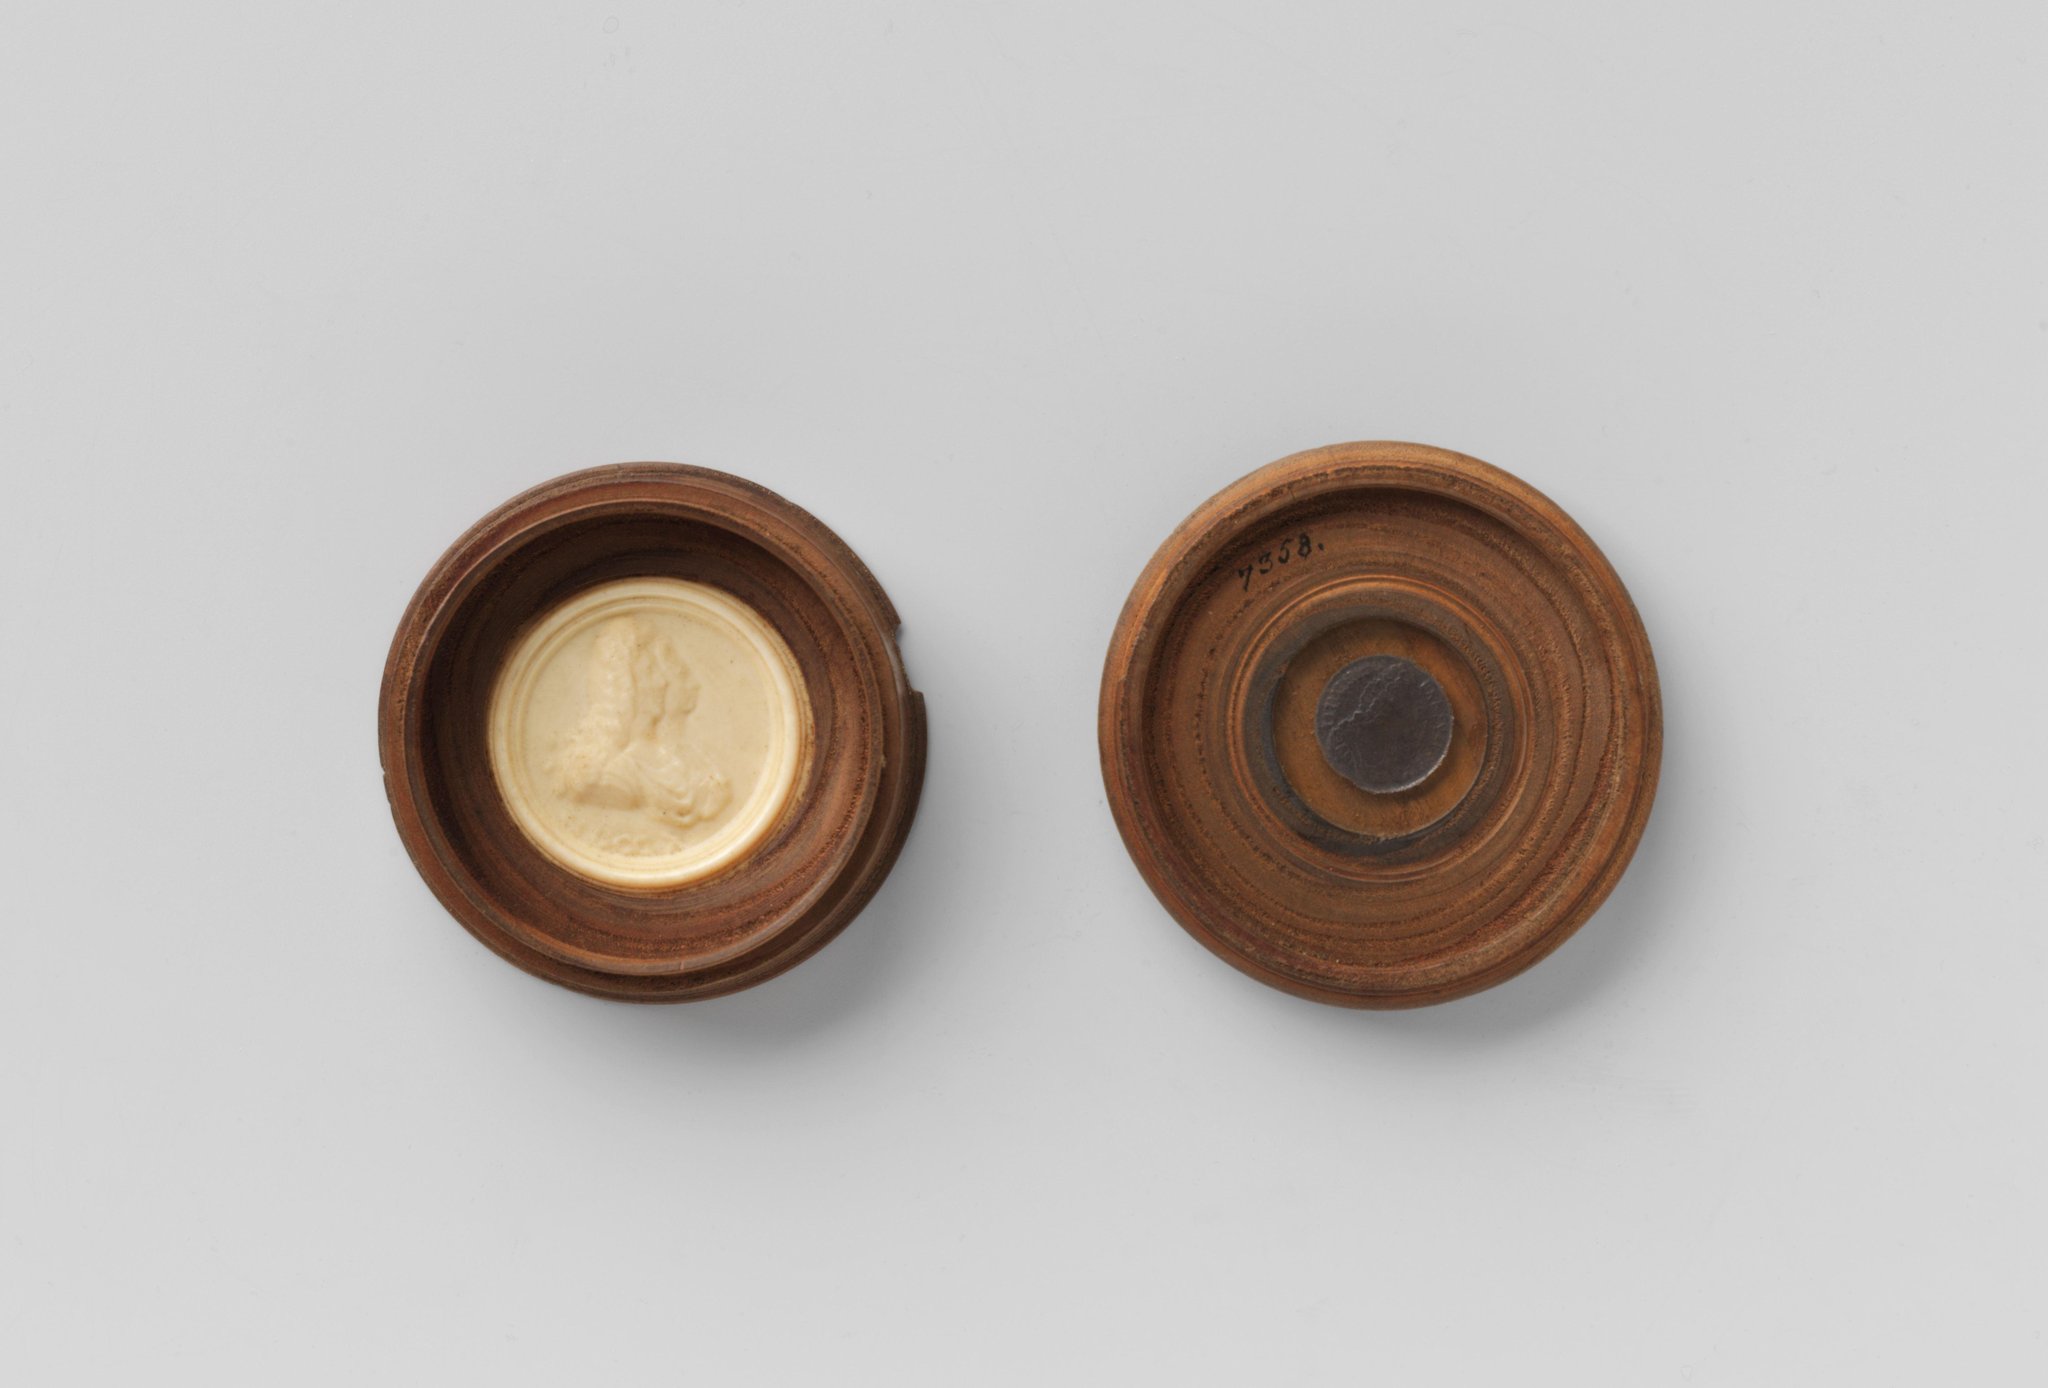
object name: history medal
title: Lodewijk XIV, koning van Frankrijk [?]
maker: Anonymous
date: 1710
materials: ivory, silver, wood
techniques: cutting, striking, turning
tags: lodewijk xiv (koning van frankrijk)